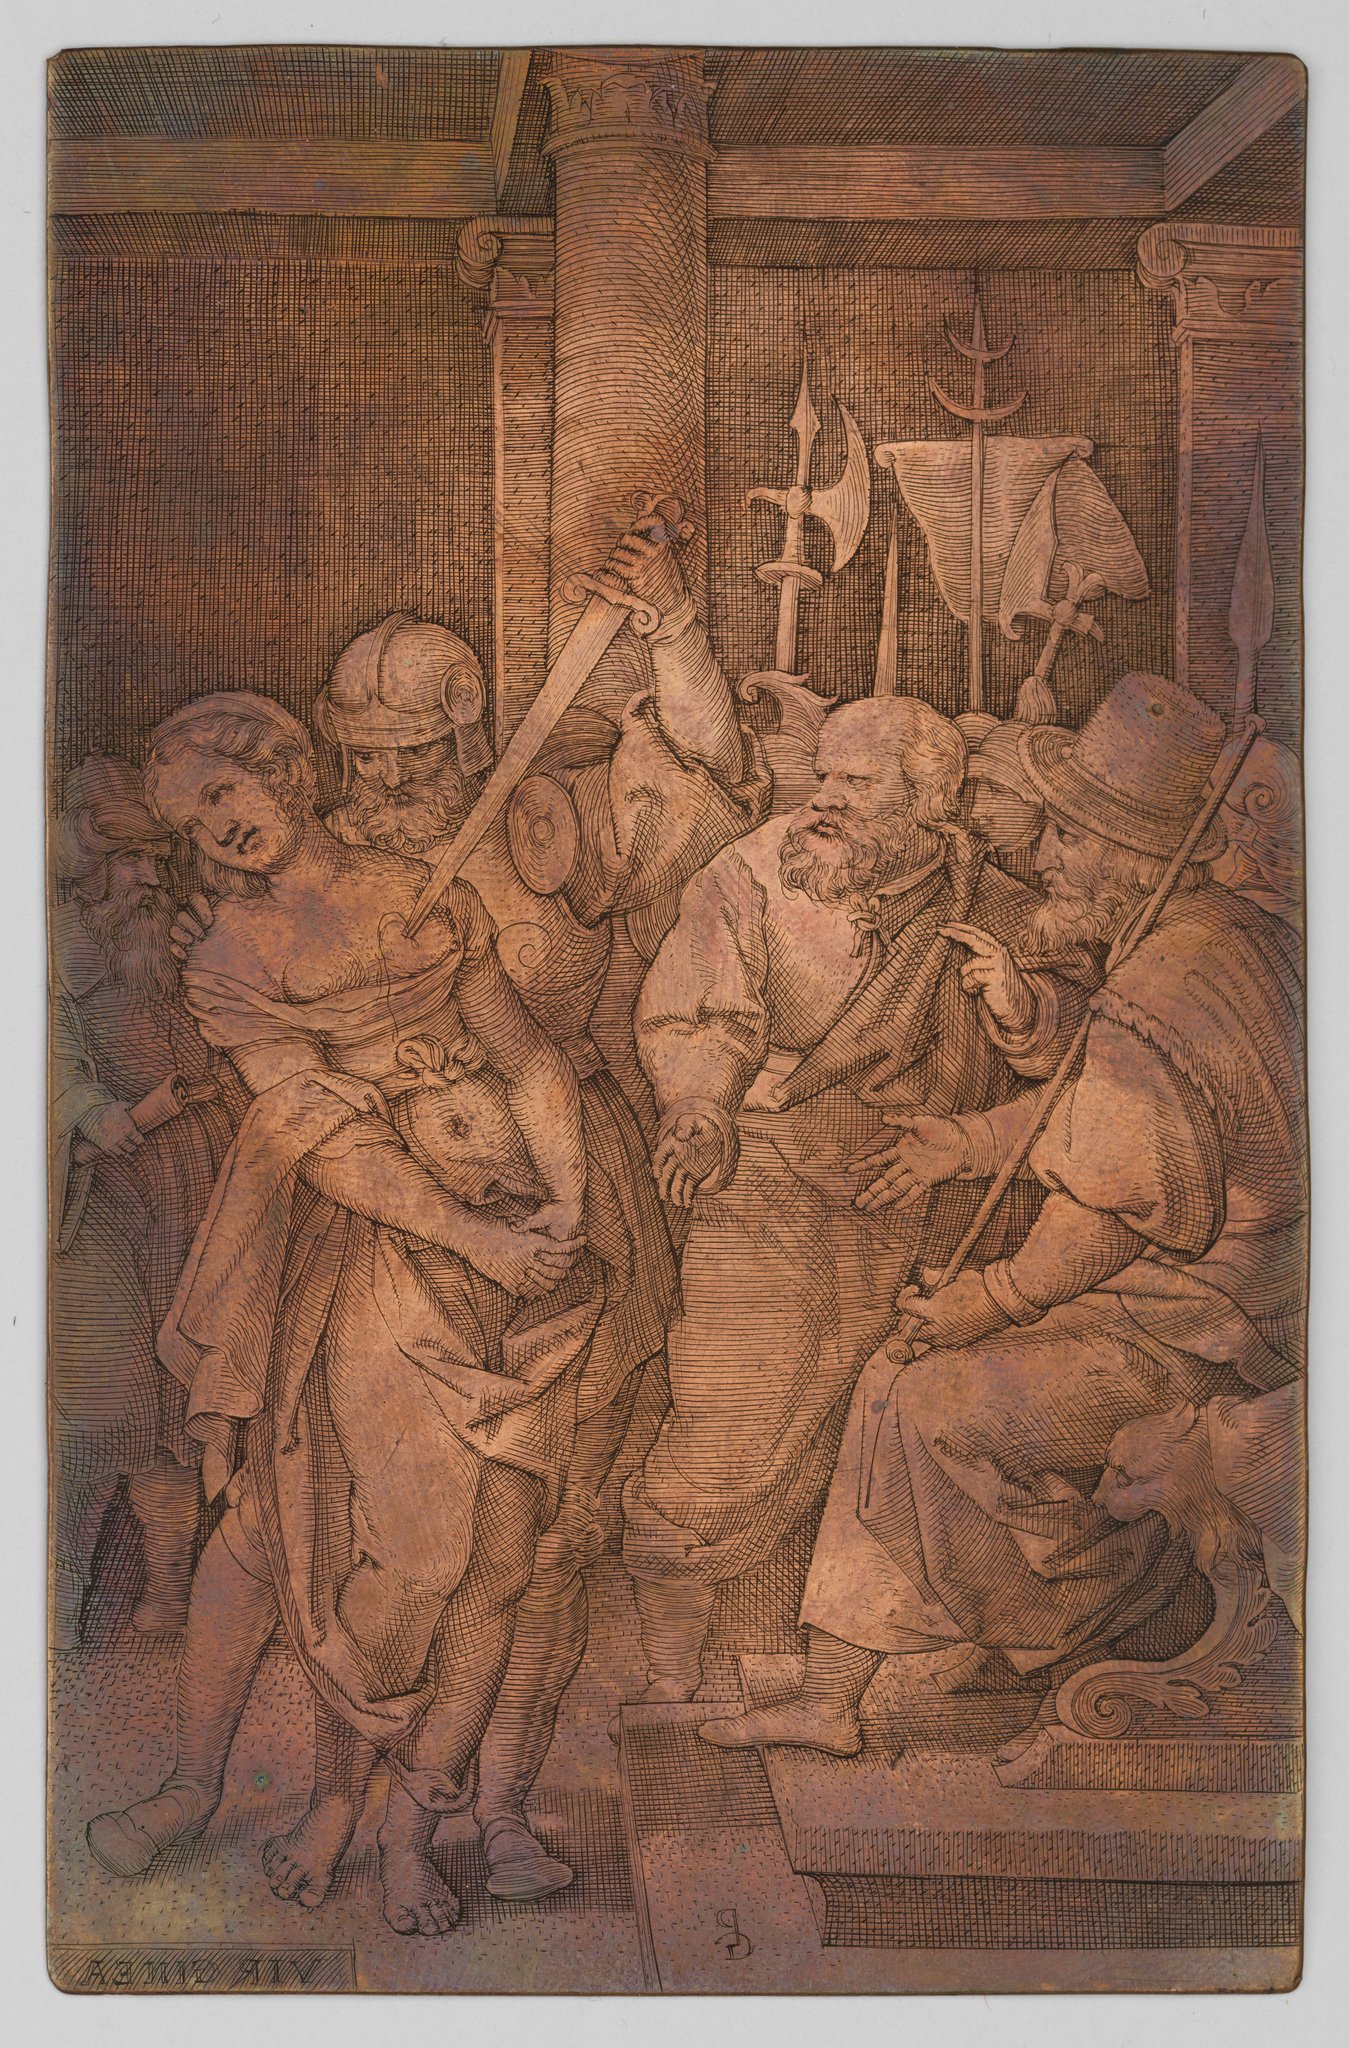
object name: plate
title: Virginia Killed by Her Father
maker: georg pencz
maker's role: artist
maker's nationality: german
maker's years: 1500-1550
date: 1520-1550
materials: copper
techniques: engraving